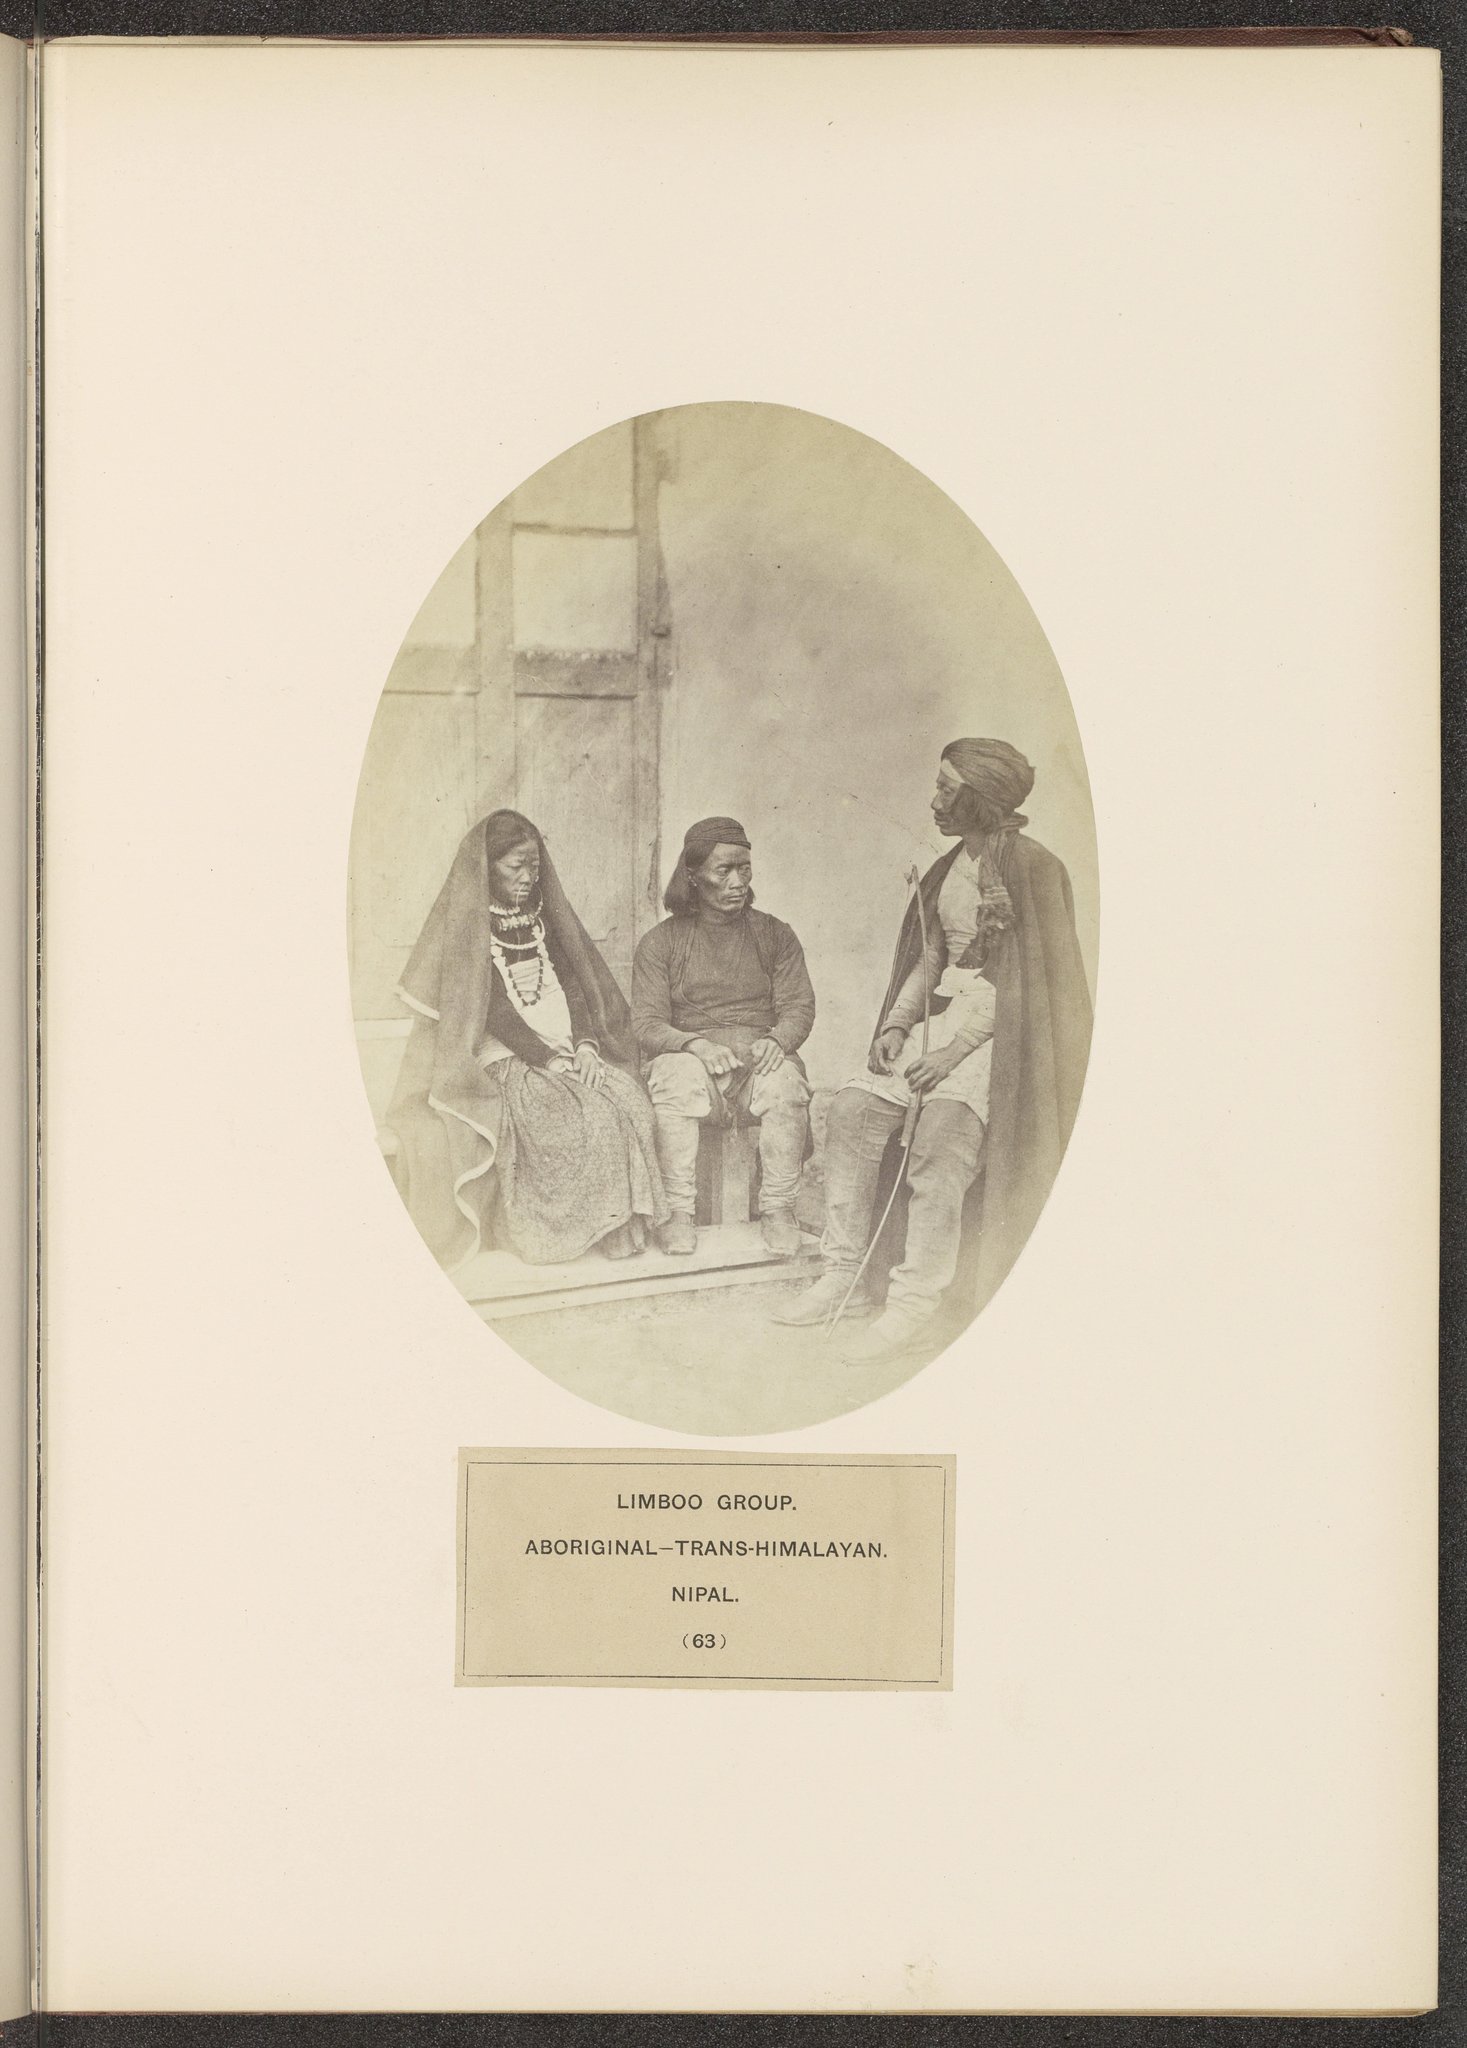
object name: page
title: Three sitting people from the Limbu tribe of Nepal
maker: benjamin simpson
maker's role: fotograaf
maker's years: 1831-1923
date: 1858-1868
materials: photographic support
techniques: albumen print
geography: nepal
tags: human races; peoples; nationalities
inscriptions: number: ‘(63)’, inscription: ‘LIMBOO GROUP./ ABORIGINAL—TRANS-HIMALAYAN./ NIPAL.’